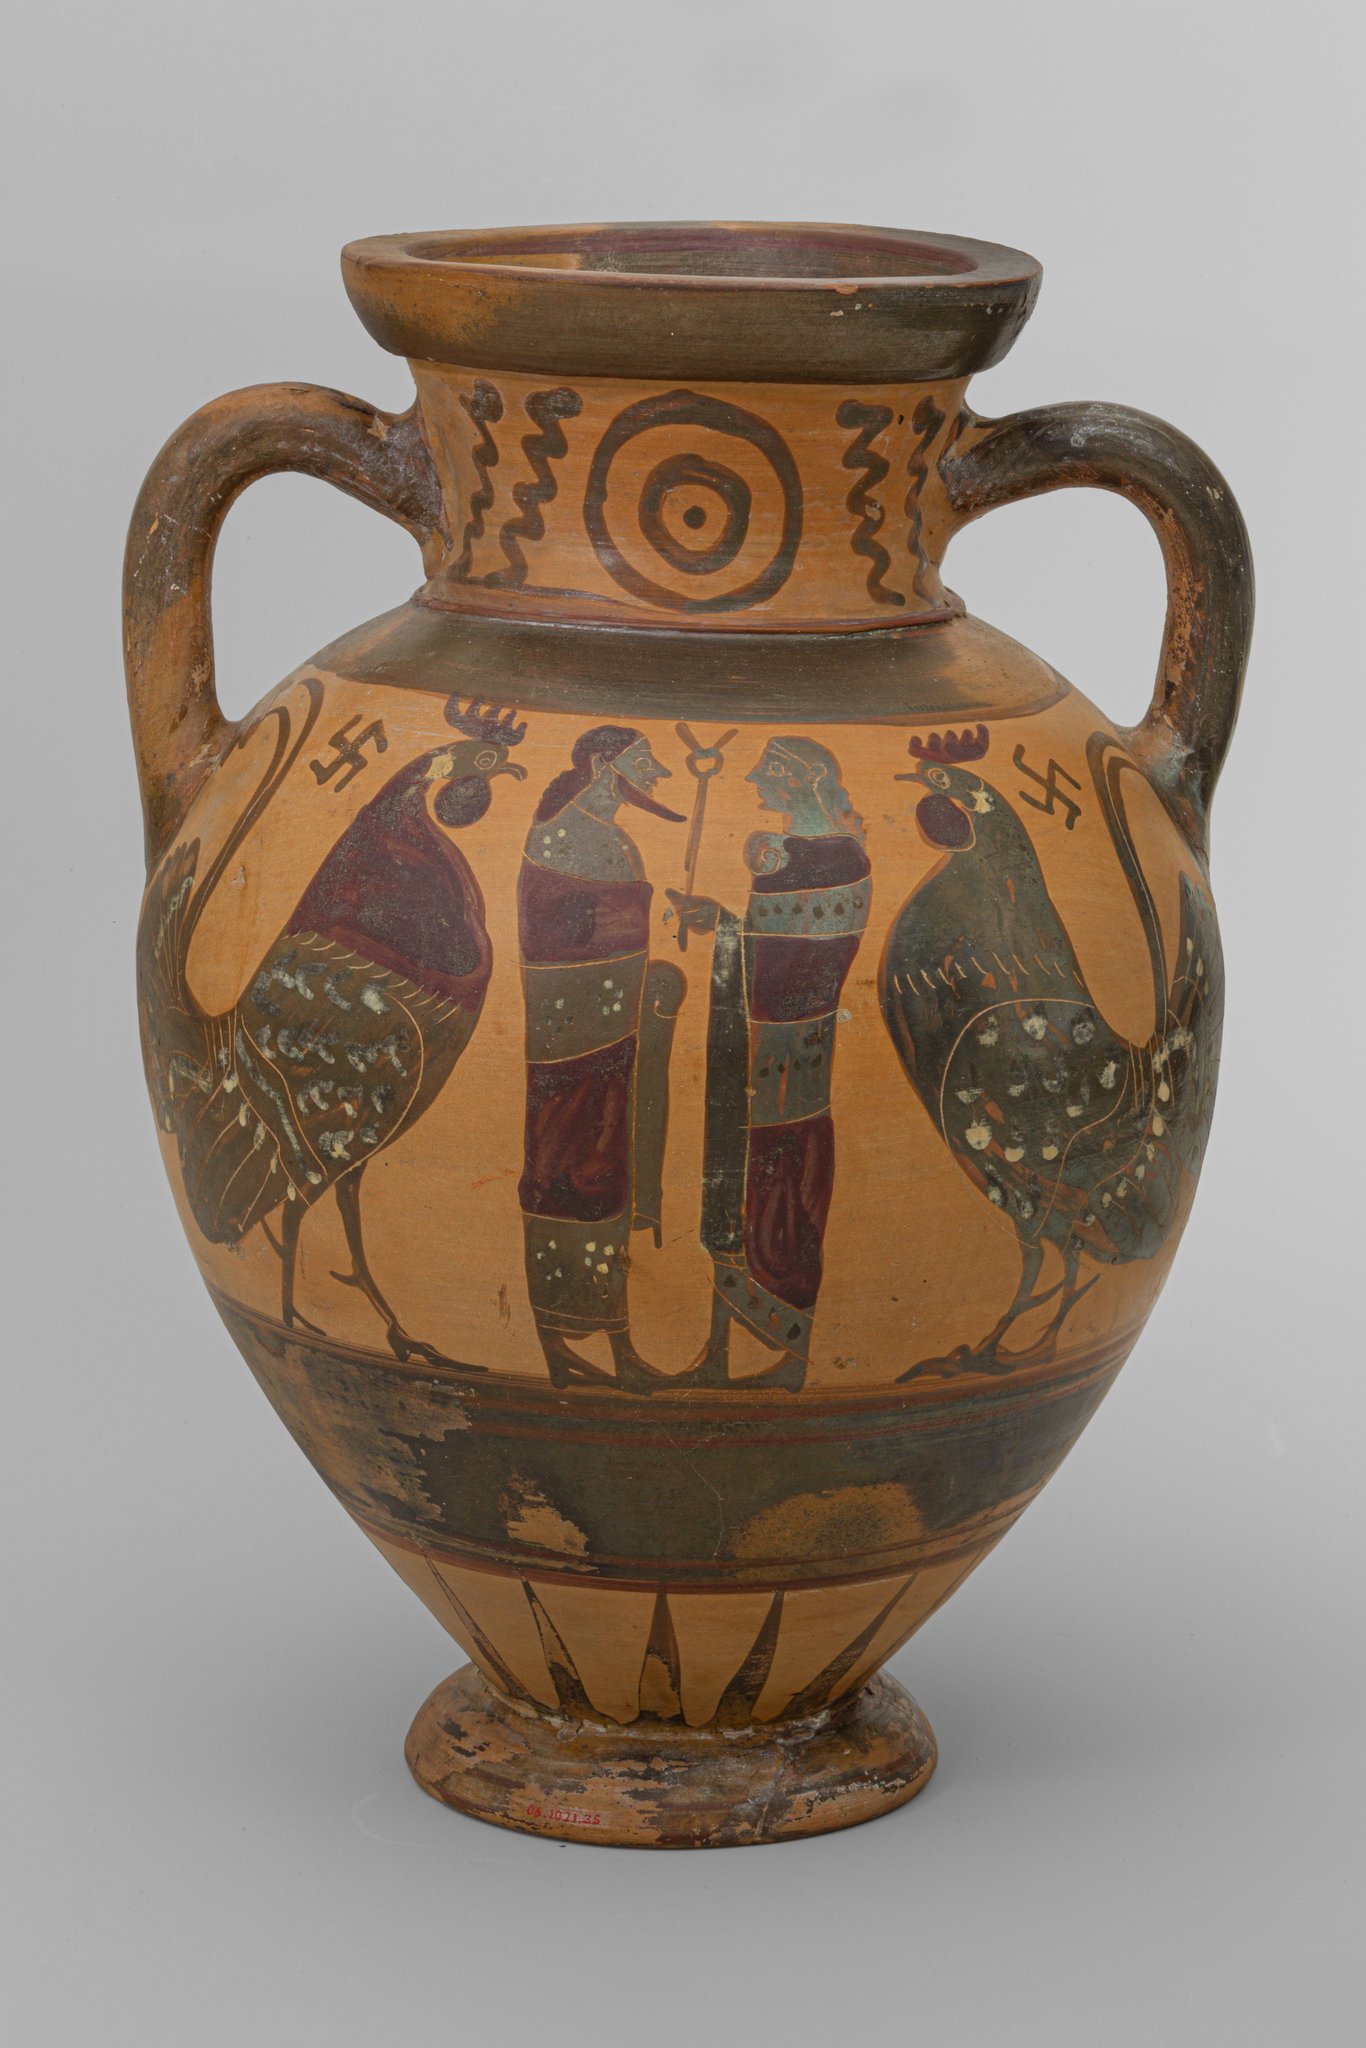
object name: neck amphora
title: Terracotta neck-amphora (storage jar)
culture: greek, euboean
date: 560 BCE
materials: terracotta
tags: men,women,roosters